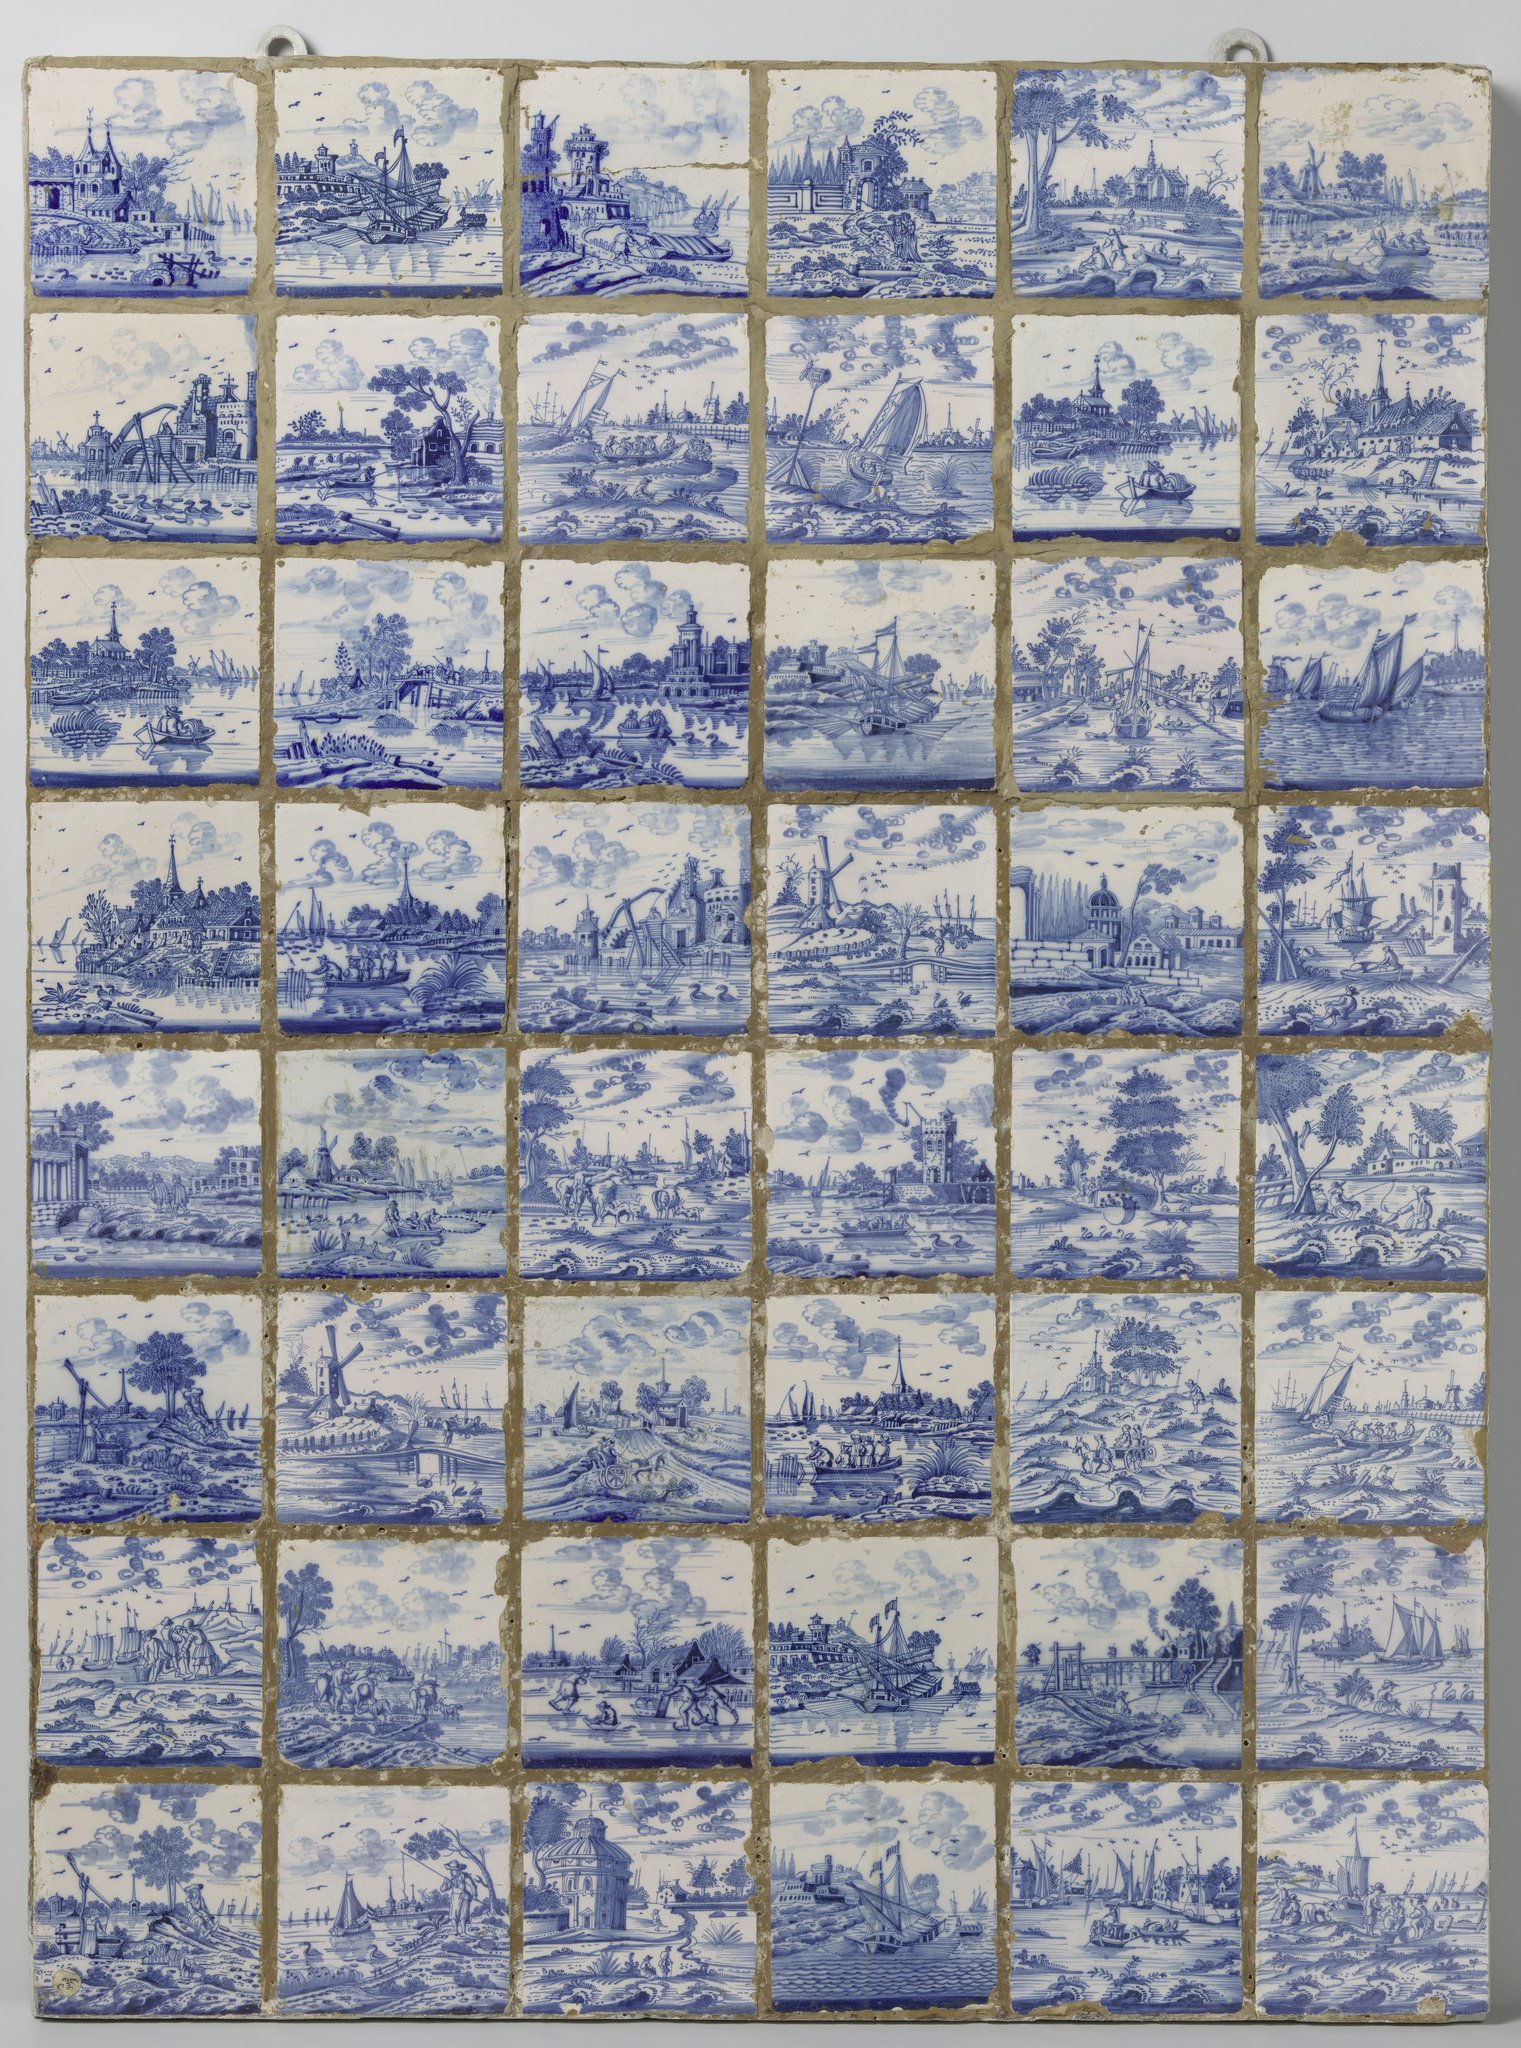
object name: tile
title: Veld van achtenveertig tegels met rivierlandschappen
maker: Anonymous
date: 1700-1750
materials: earthenware, glaze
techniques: maiolica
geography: amsterdam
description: Tegelveld van achtenveertig tegels (8 x 6) met elk een blauw geschilderd landschap met riviergezichten.